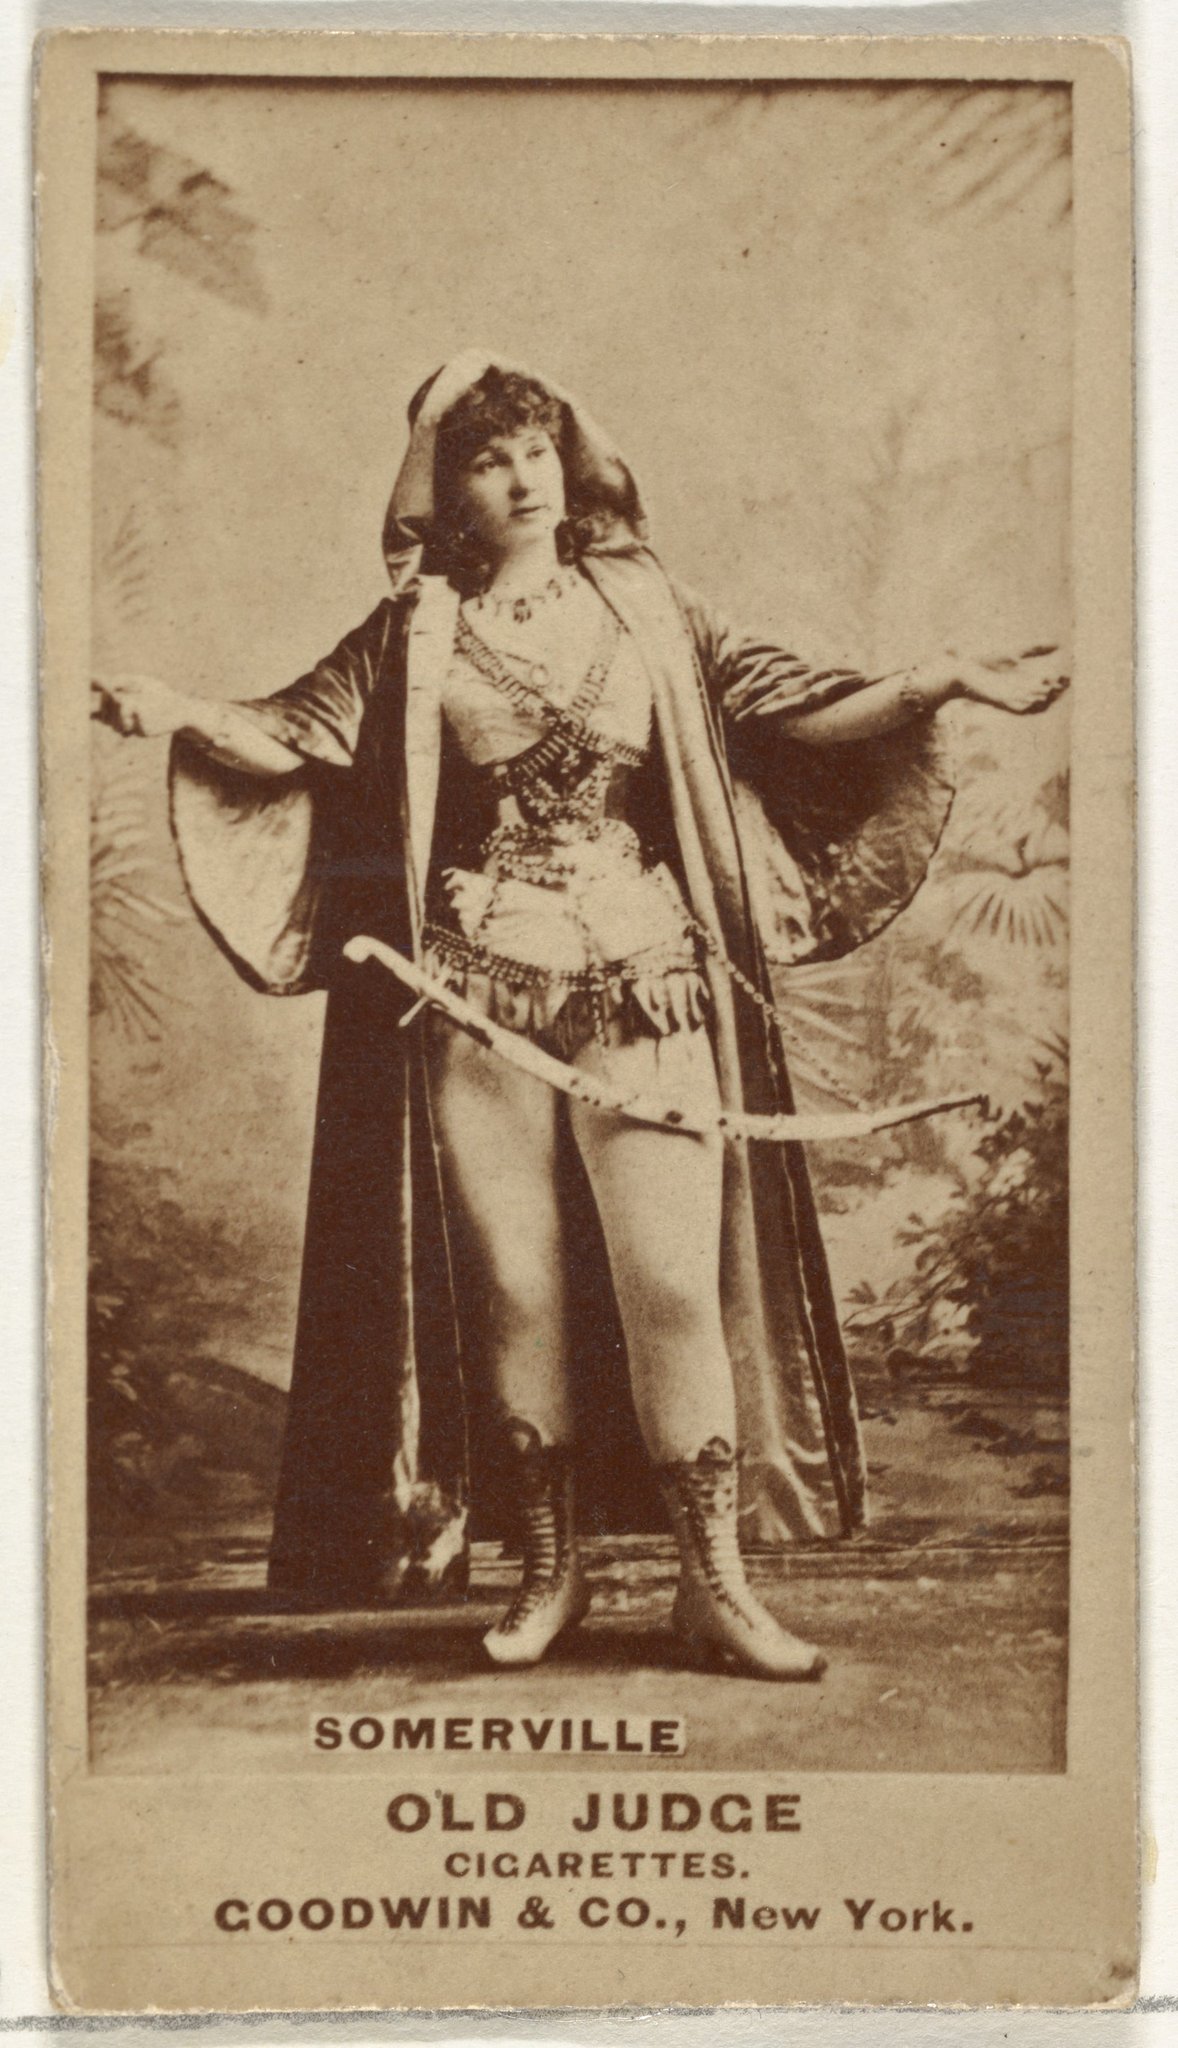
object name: photograph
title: Annie Somerville, from the Actors and Actresses series (N171) for Old Judge Cigarettes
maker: goodwin & company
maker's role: publisher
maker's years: 1850-1950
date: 1886-1890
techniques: albumen silver print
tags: swords,women